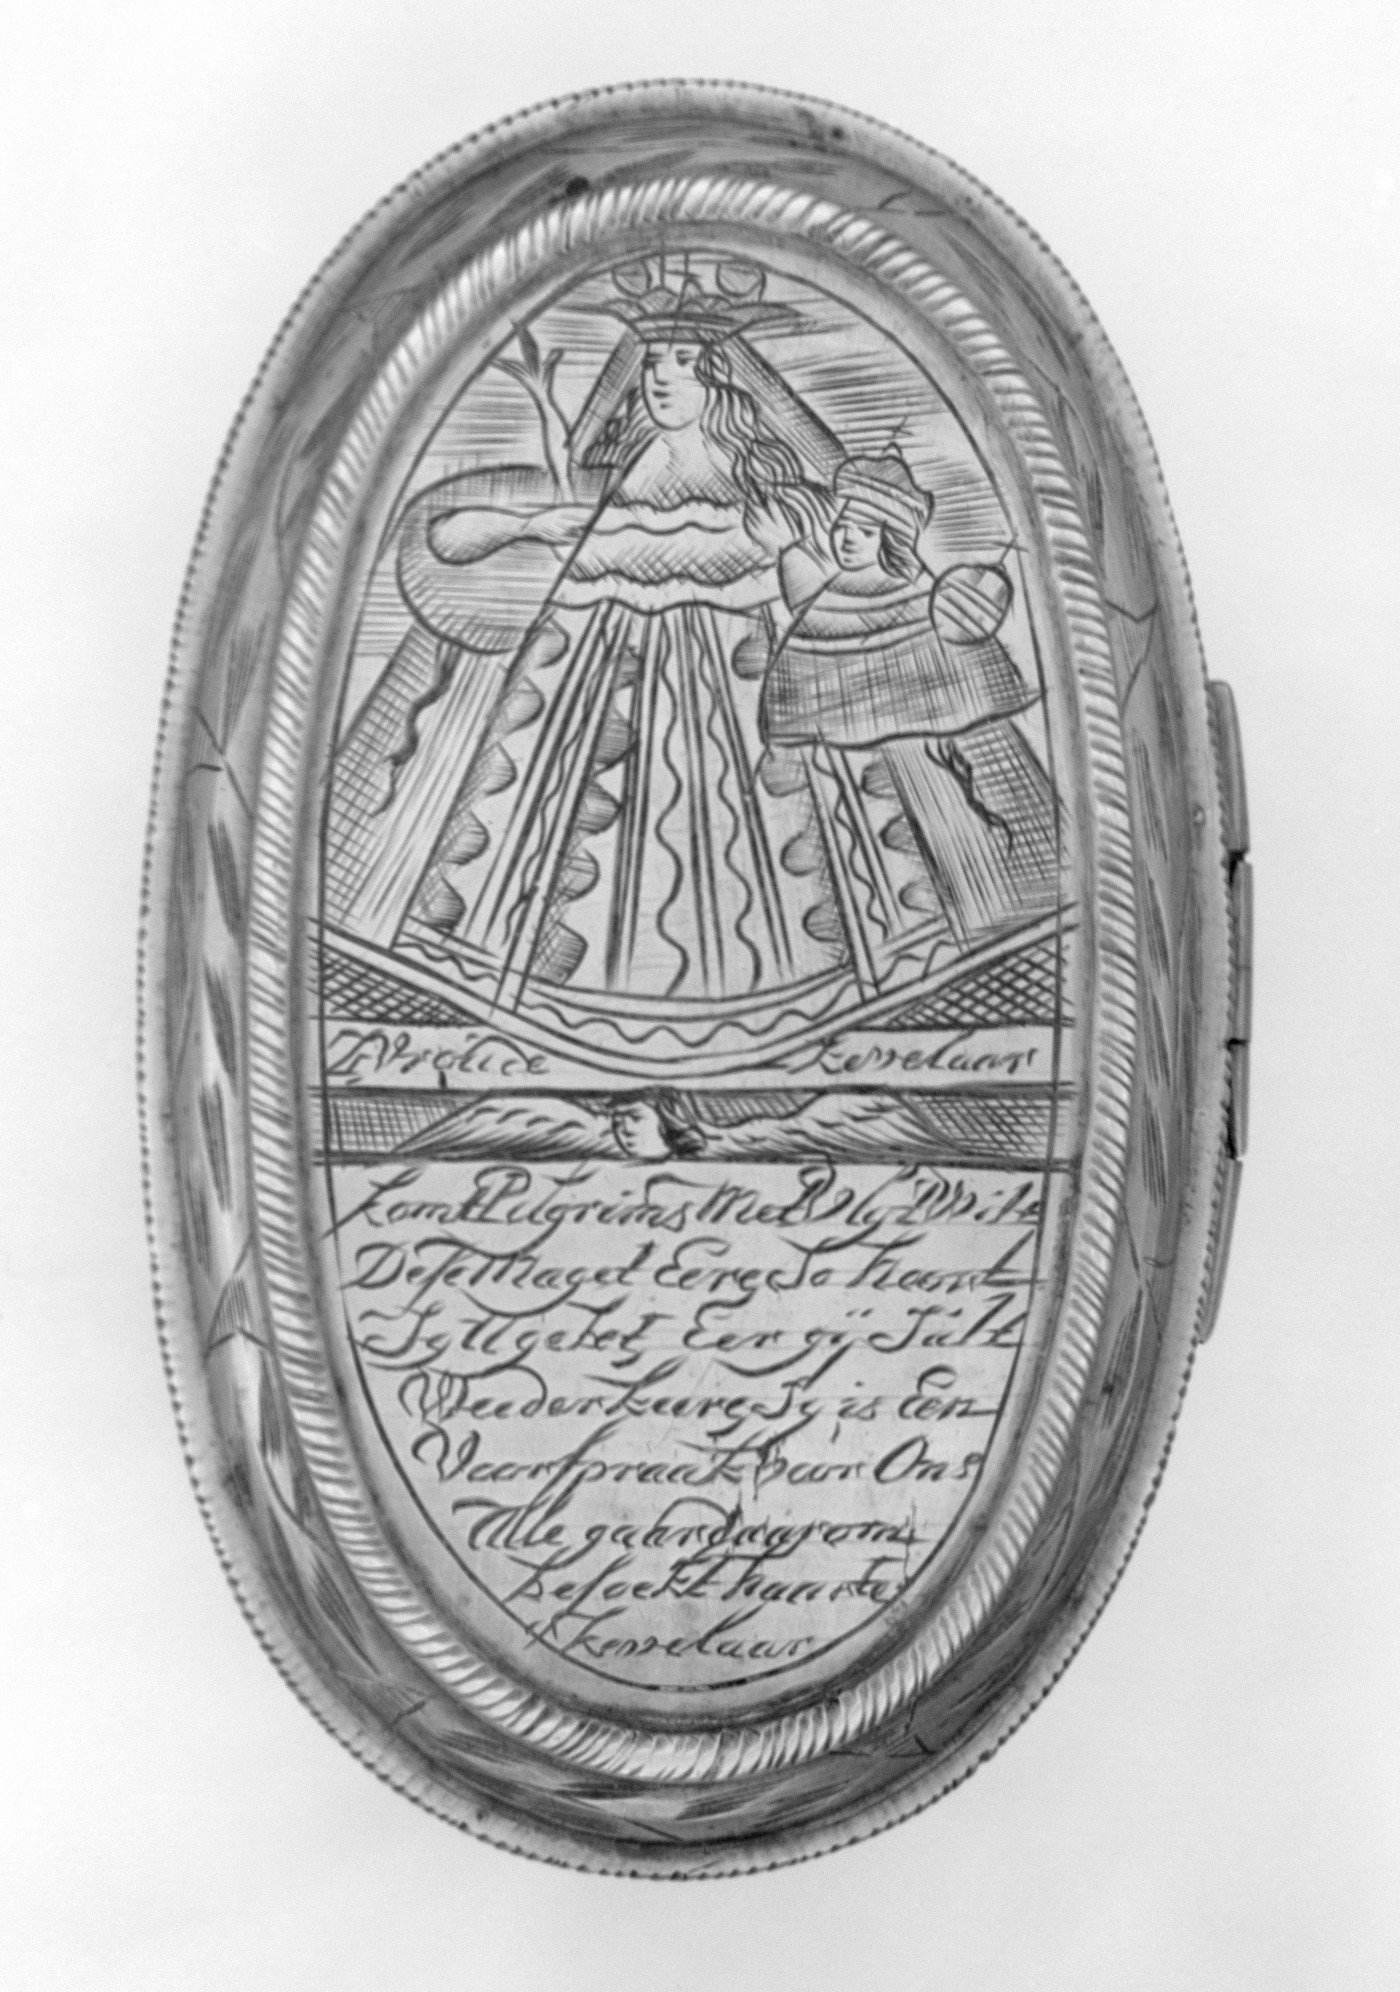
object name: tobacco box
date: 1667-1700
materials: brass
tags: madonna and child